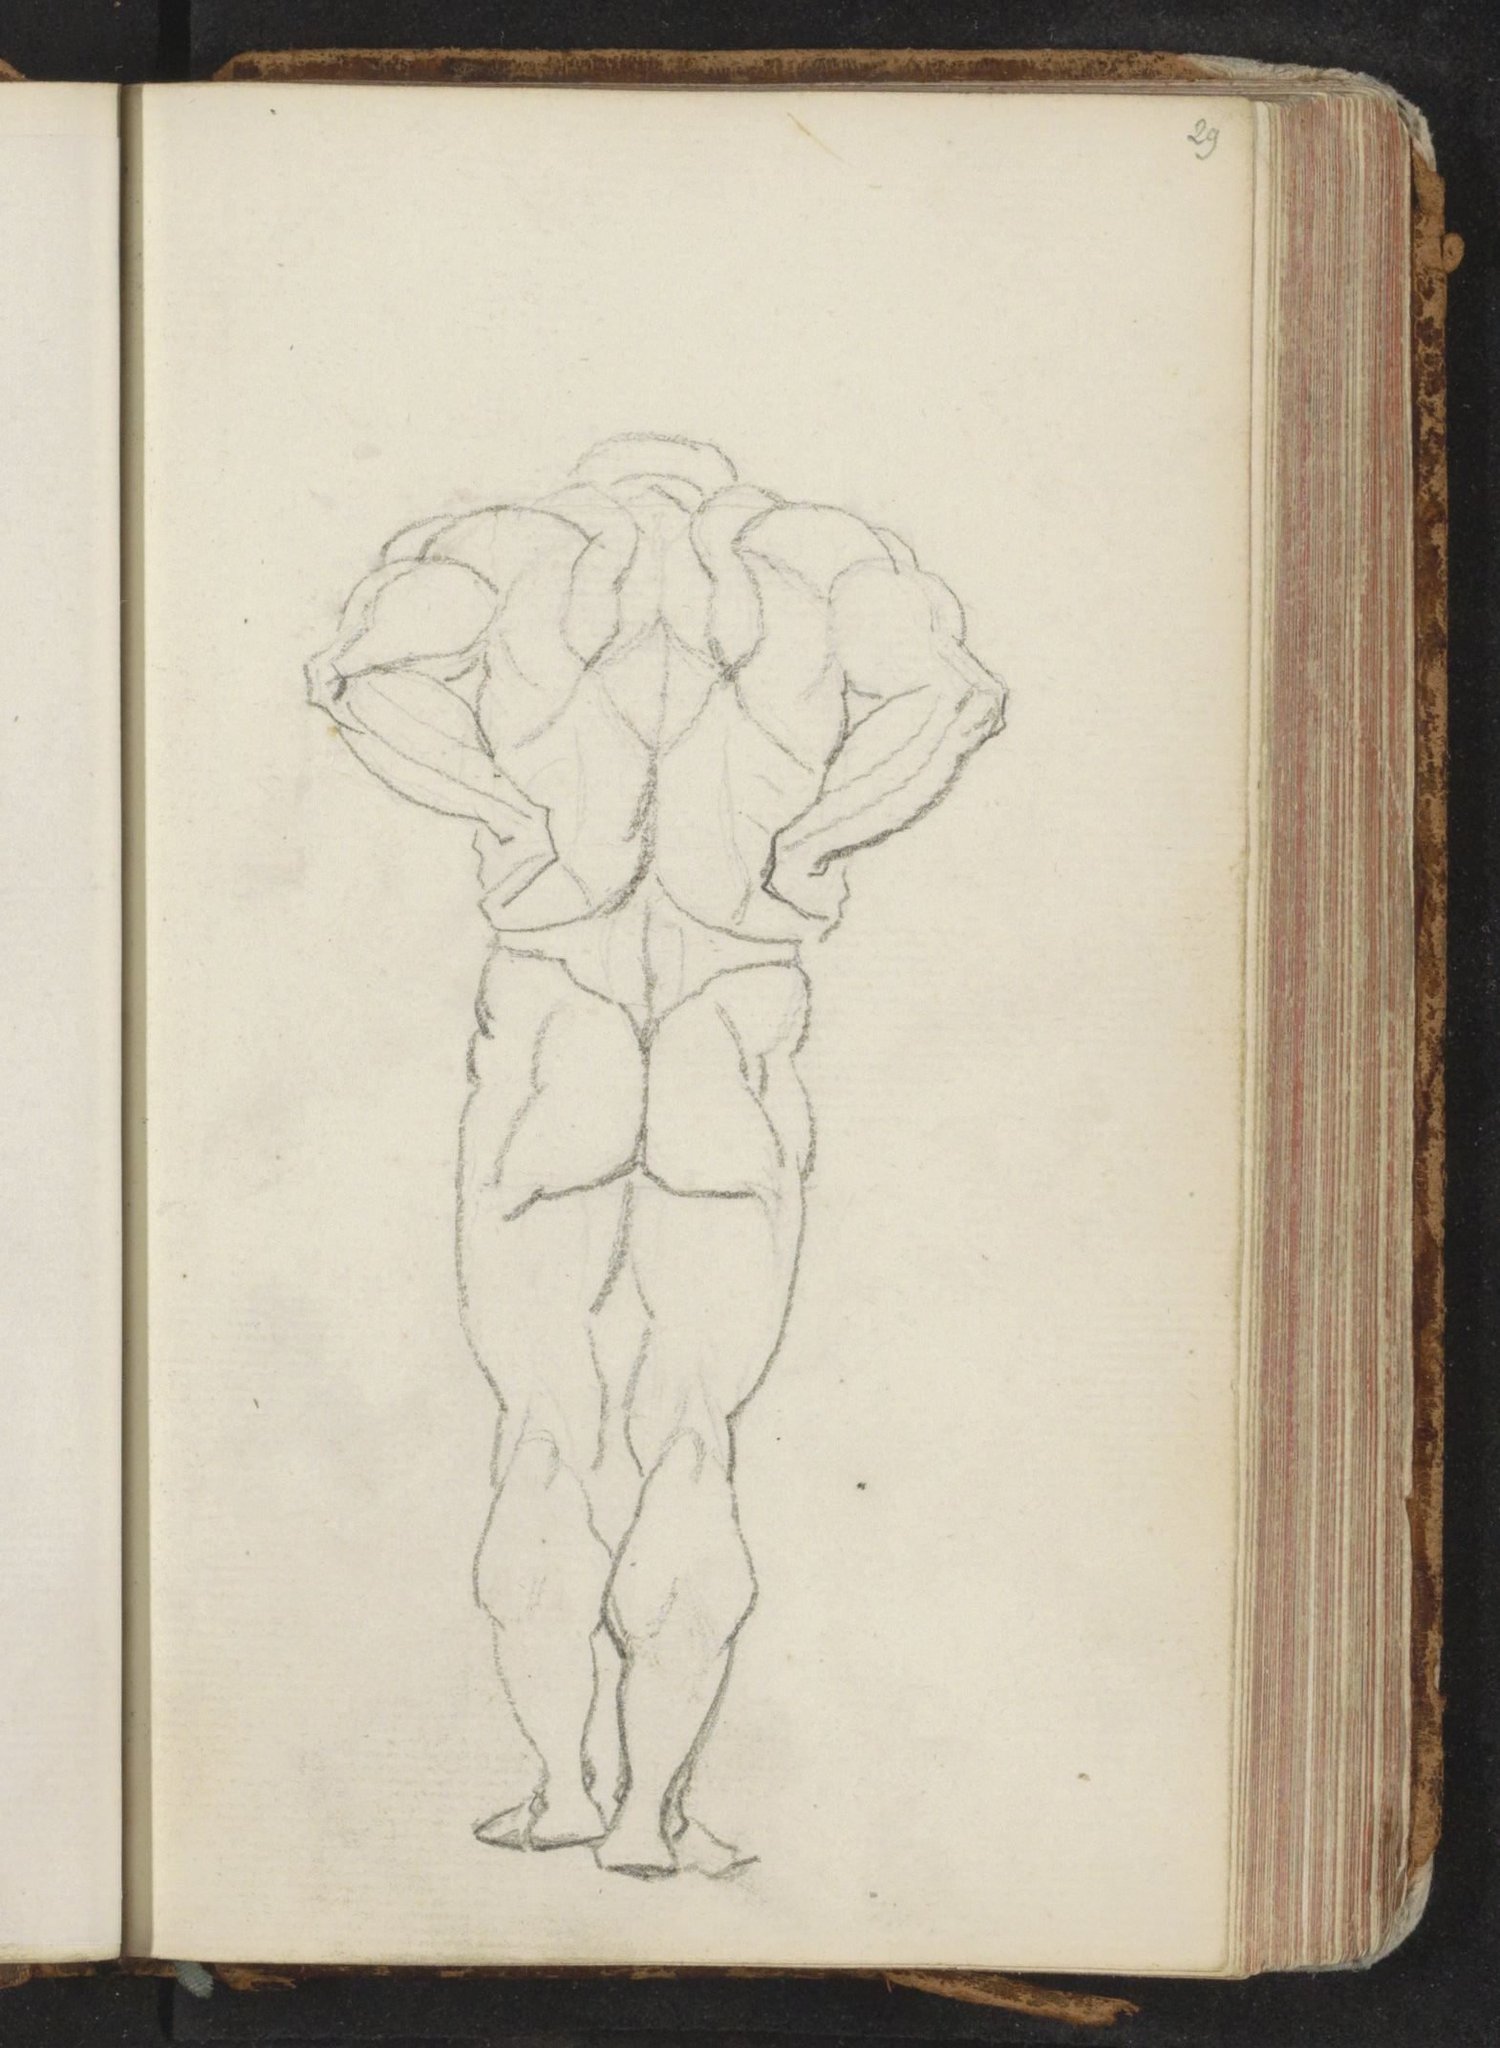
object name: sketchbook leaf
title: Staande man met spierbundels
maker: jean honoré fragonard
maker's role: draughtsman, painter, print maker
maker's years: 1732-1806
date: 1765-1775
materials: paper, pencil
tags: muscles, the (nude) human figure; 'corpo humano' (ripa) (+ back view)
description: Blad 29 recto uit een schetsboek met 83 bladen.